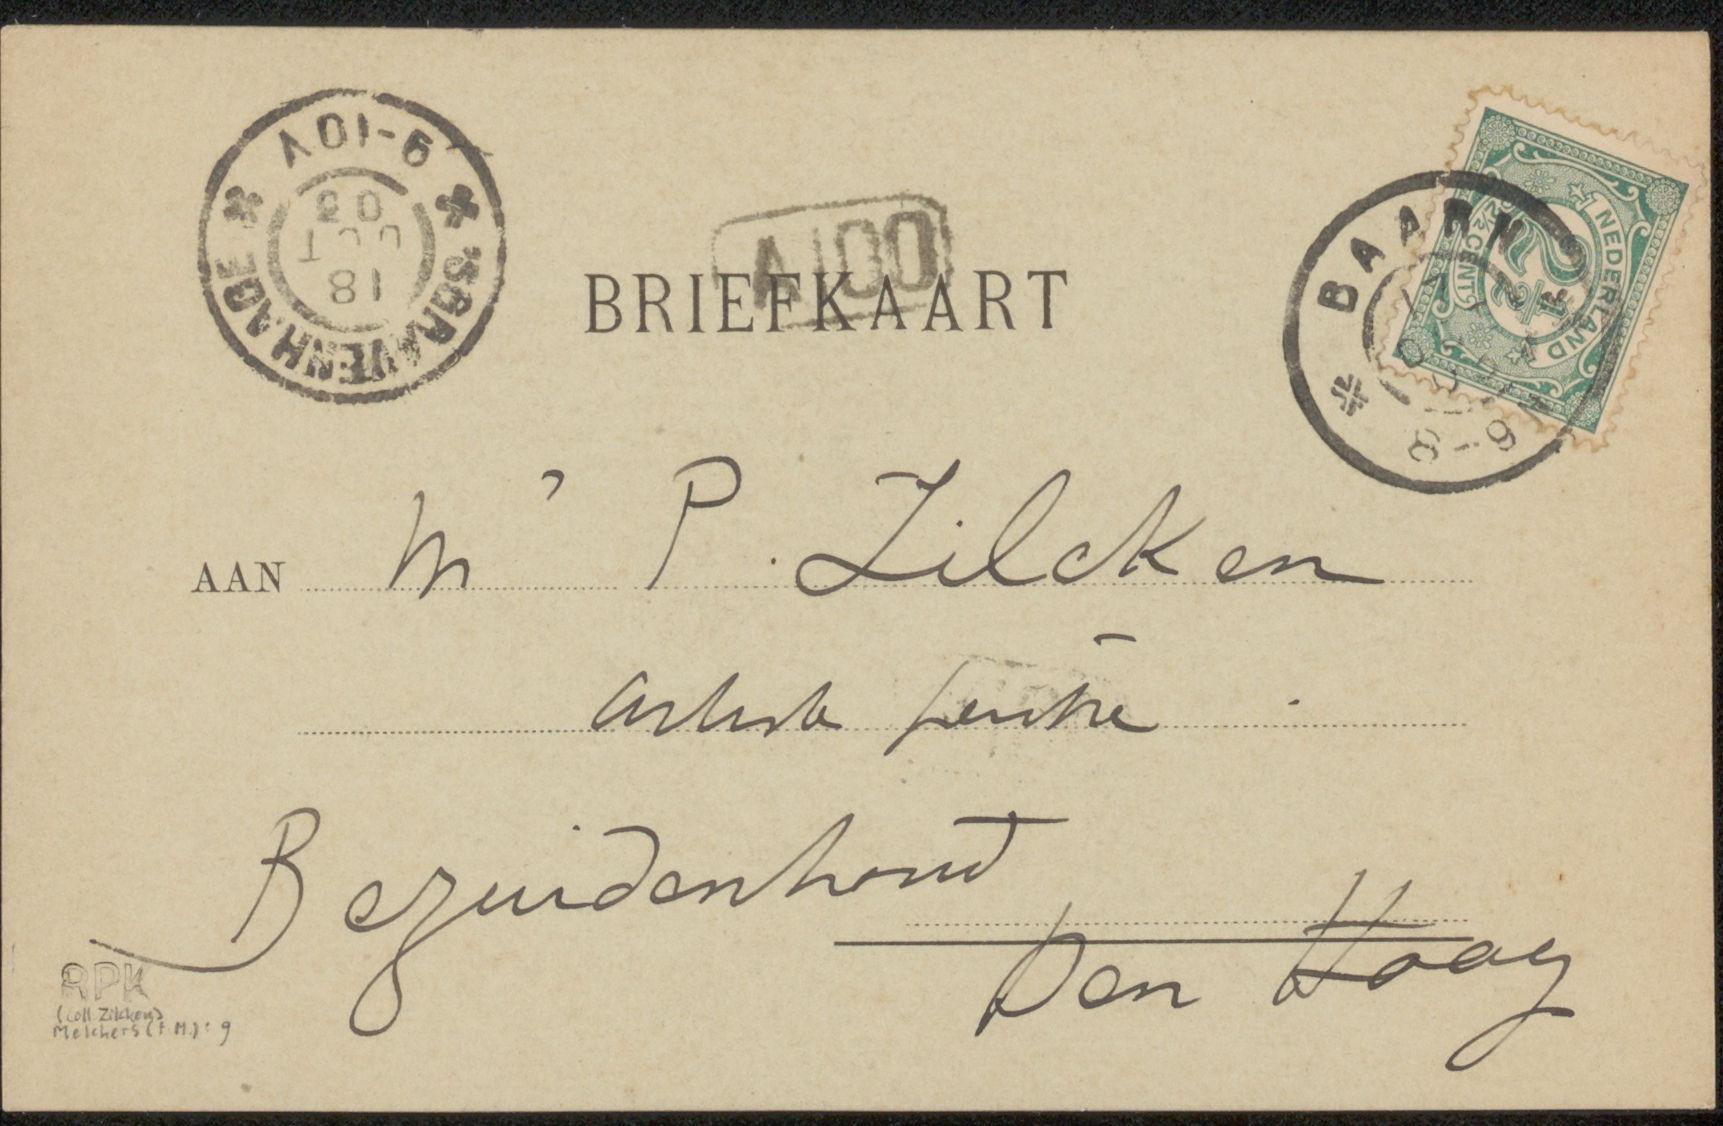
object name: postcard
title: Briefkaart aan Philip Zilcken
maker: franz melchers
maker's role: draughtsman, painter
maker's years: 1868-1944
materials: cardboard, ink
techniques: pen, writing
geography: baarn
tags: the hague, philip zilcken, painting (including book-illumination, miniature-painting), exhibition ~ art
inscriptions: collector's mark: ‘RPK’